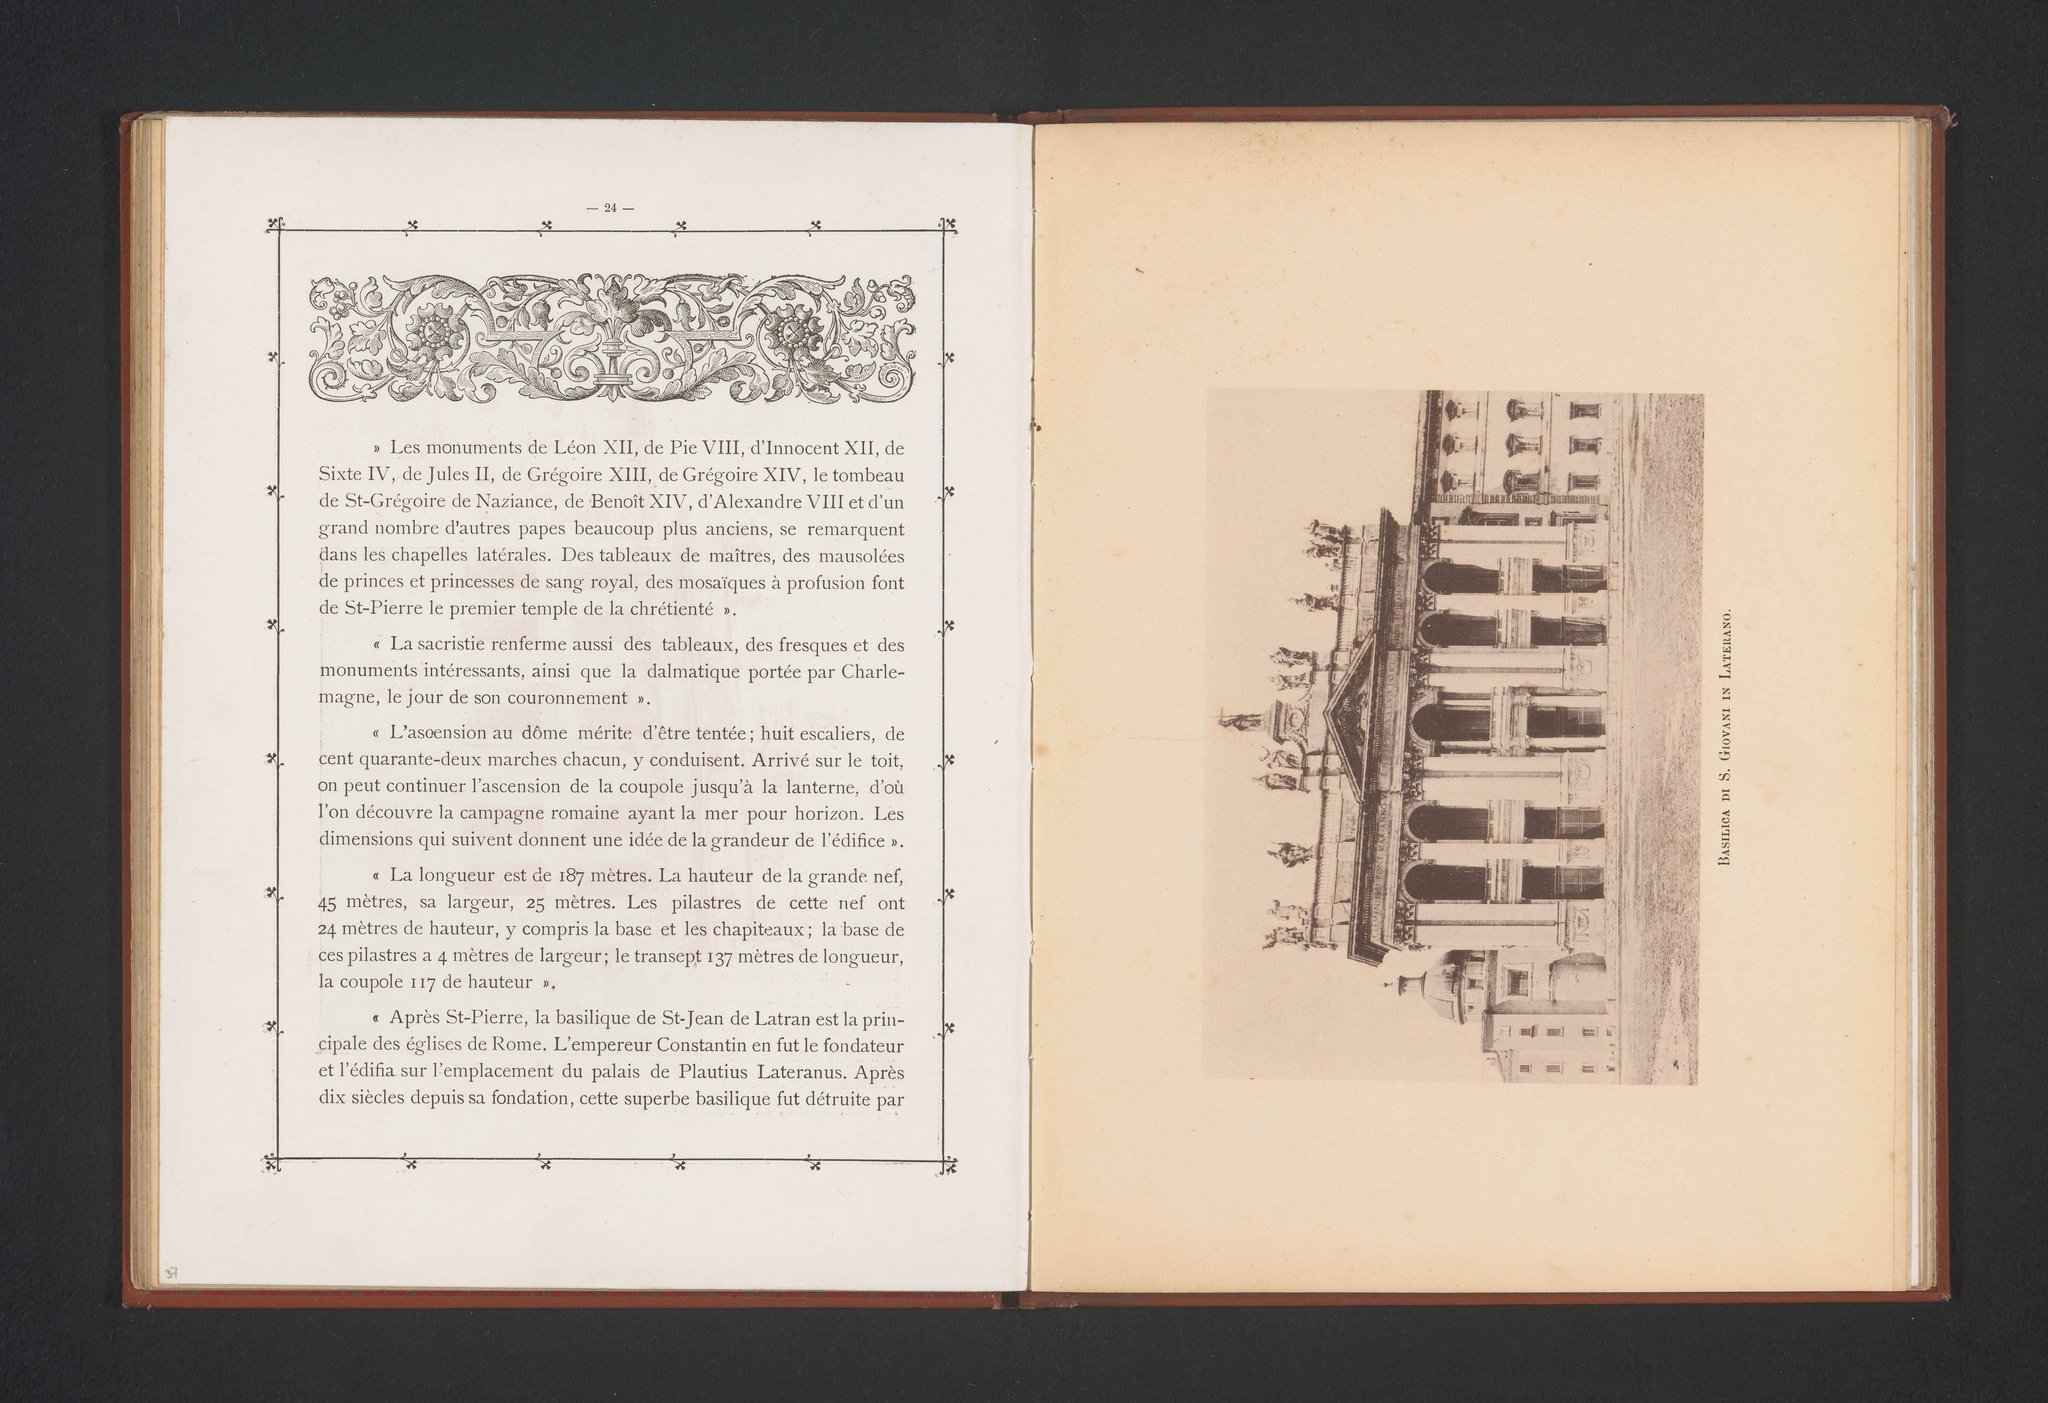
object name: page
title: Gezicht op de Sint-Jan van Lateranen in Rome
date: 1893-1898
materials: paper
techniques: photograph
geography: rome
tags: church (exterior)